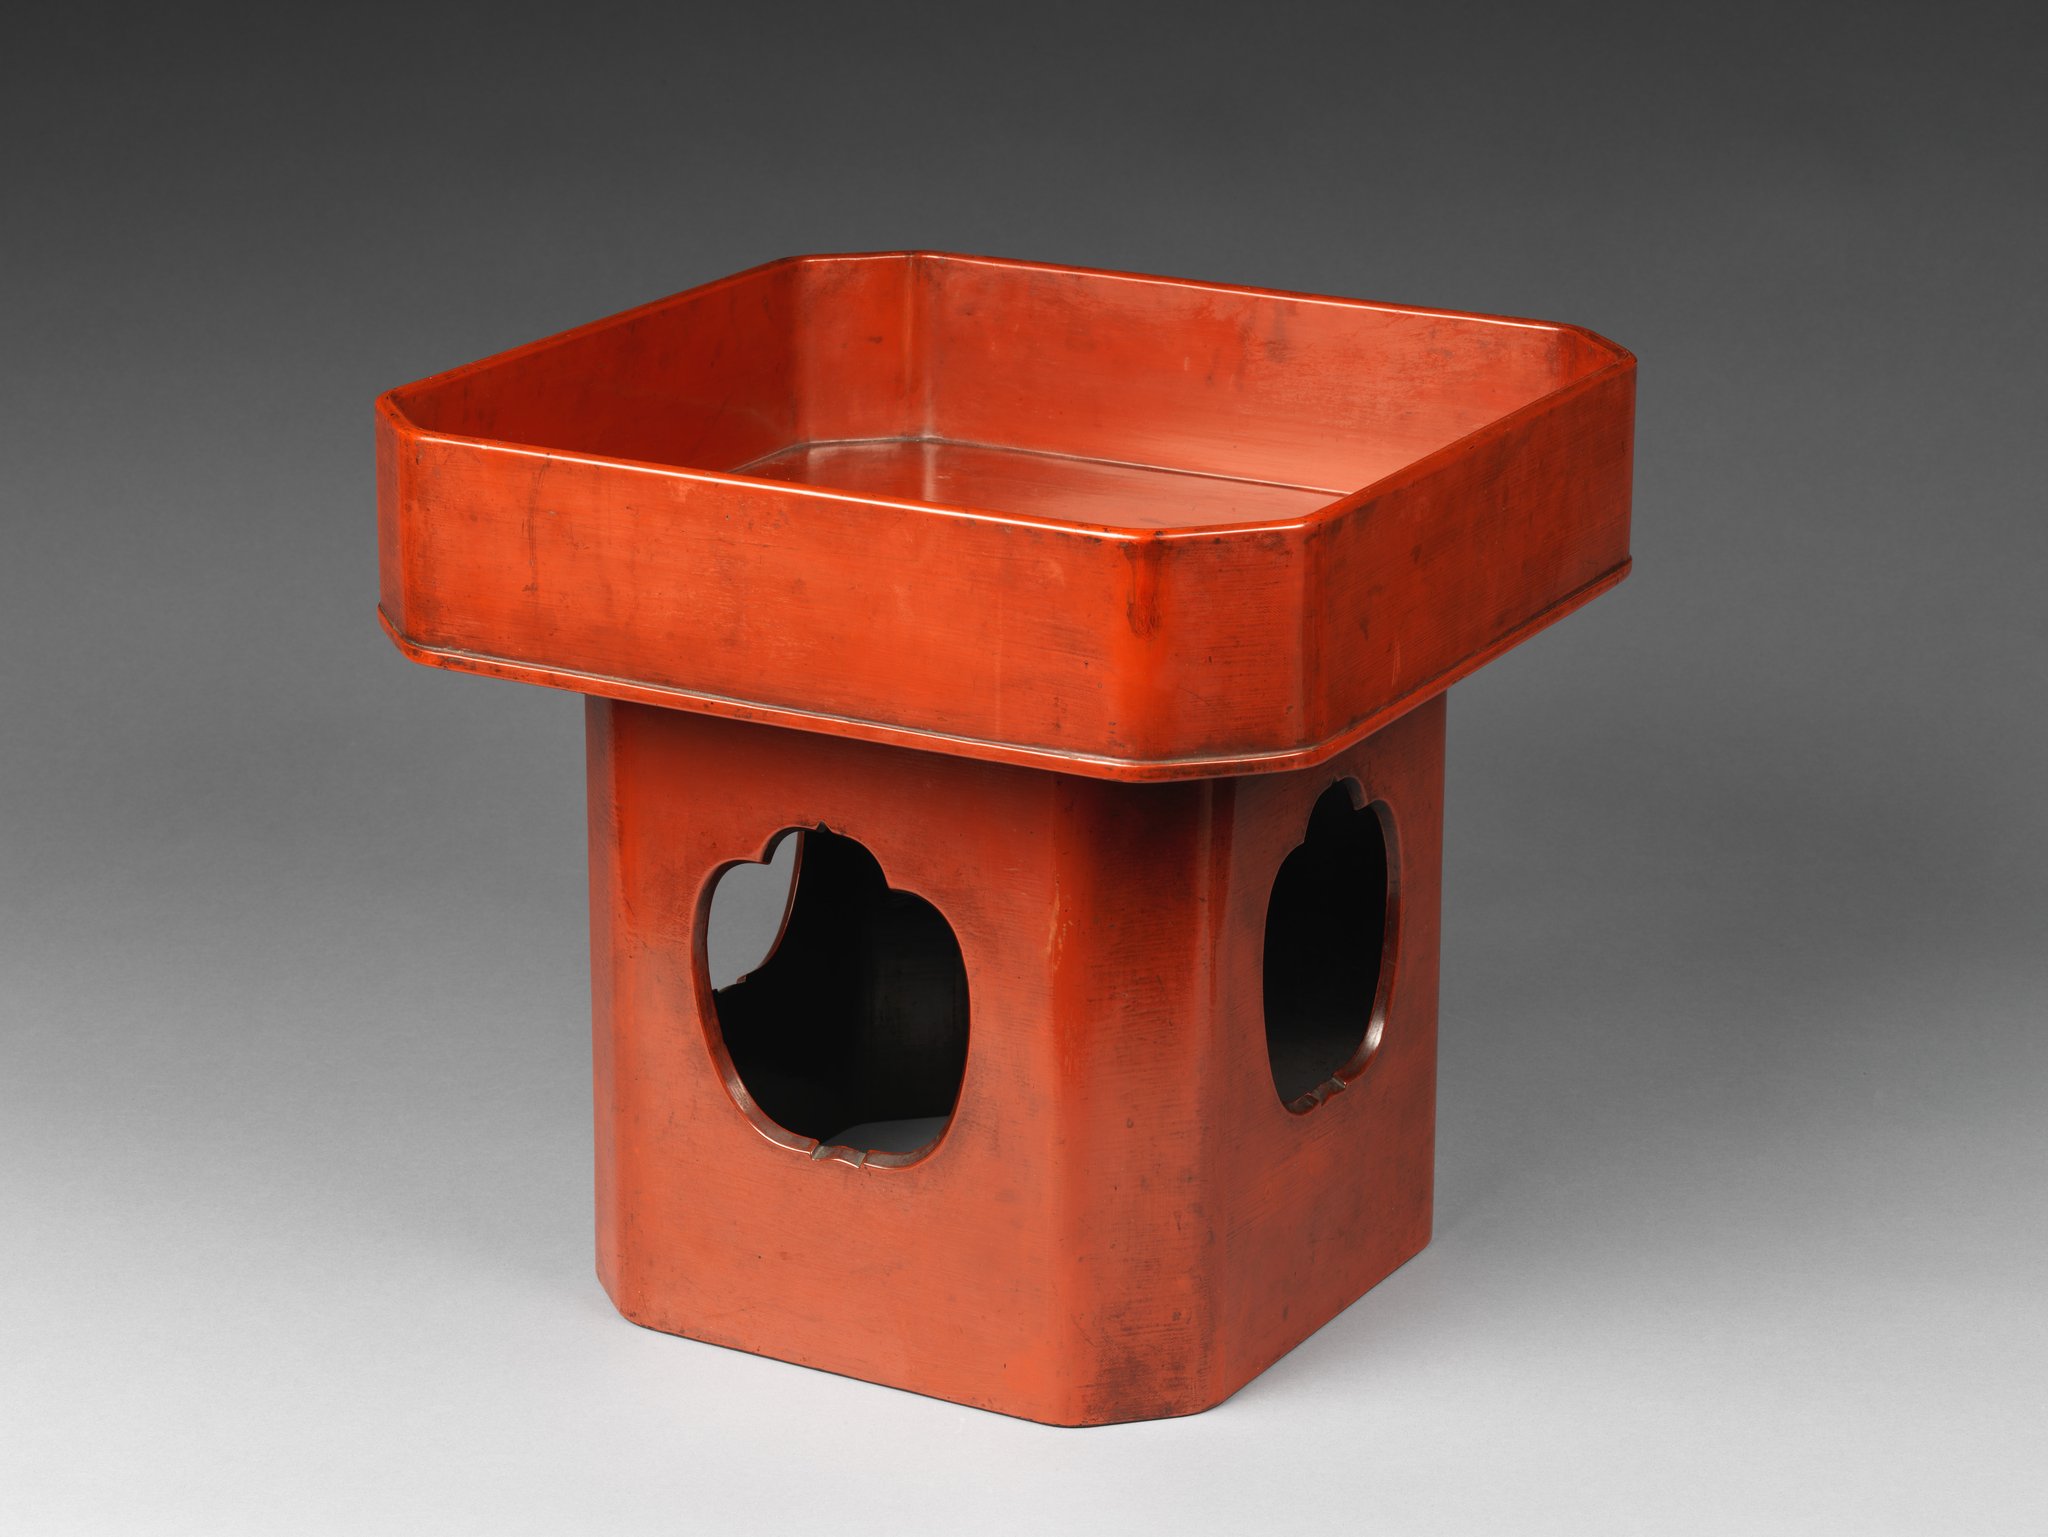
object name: table tray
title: Table Tray (Tsuigasane)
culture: japanese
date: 1601-1633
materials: lacquer, wood